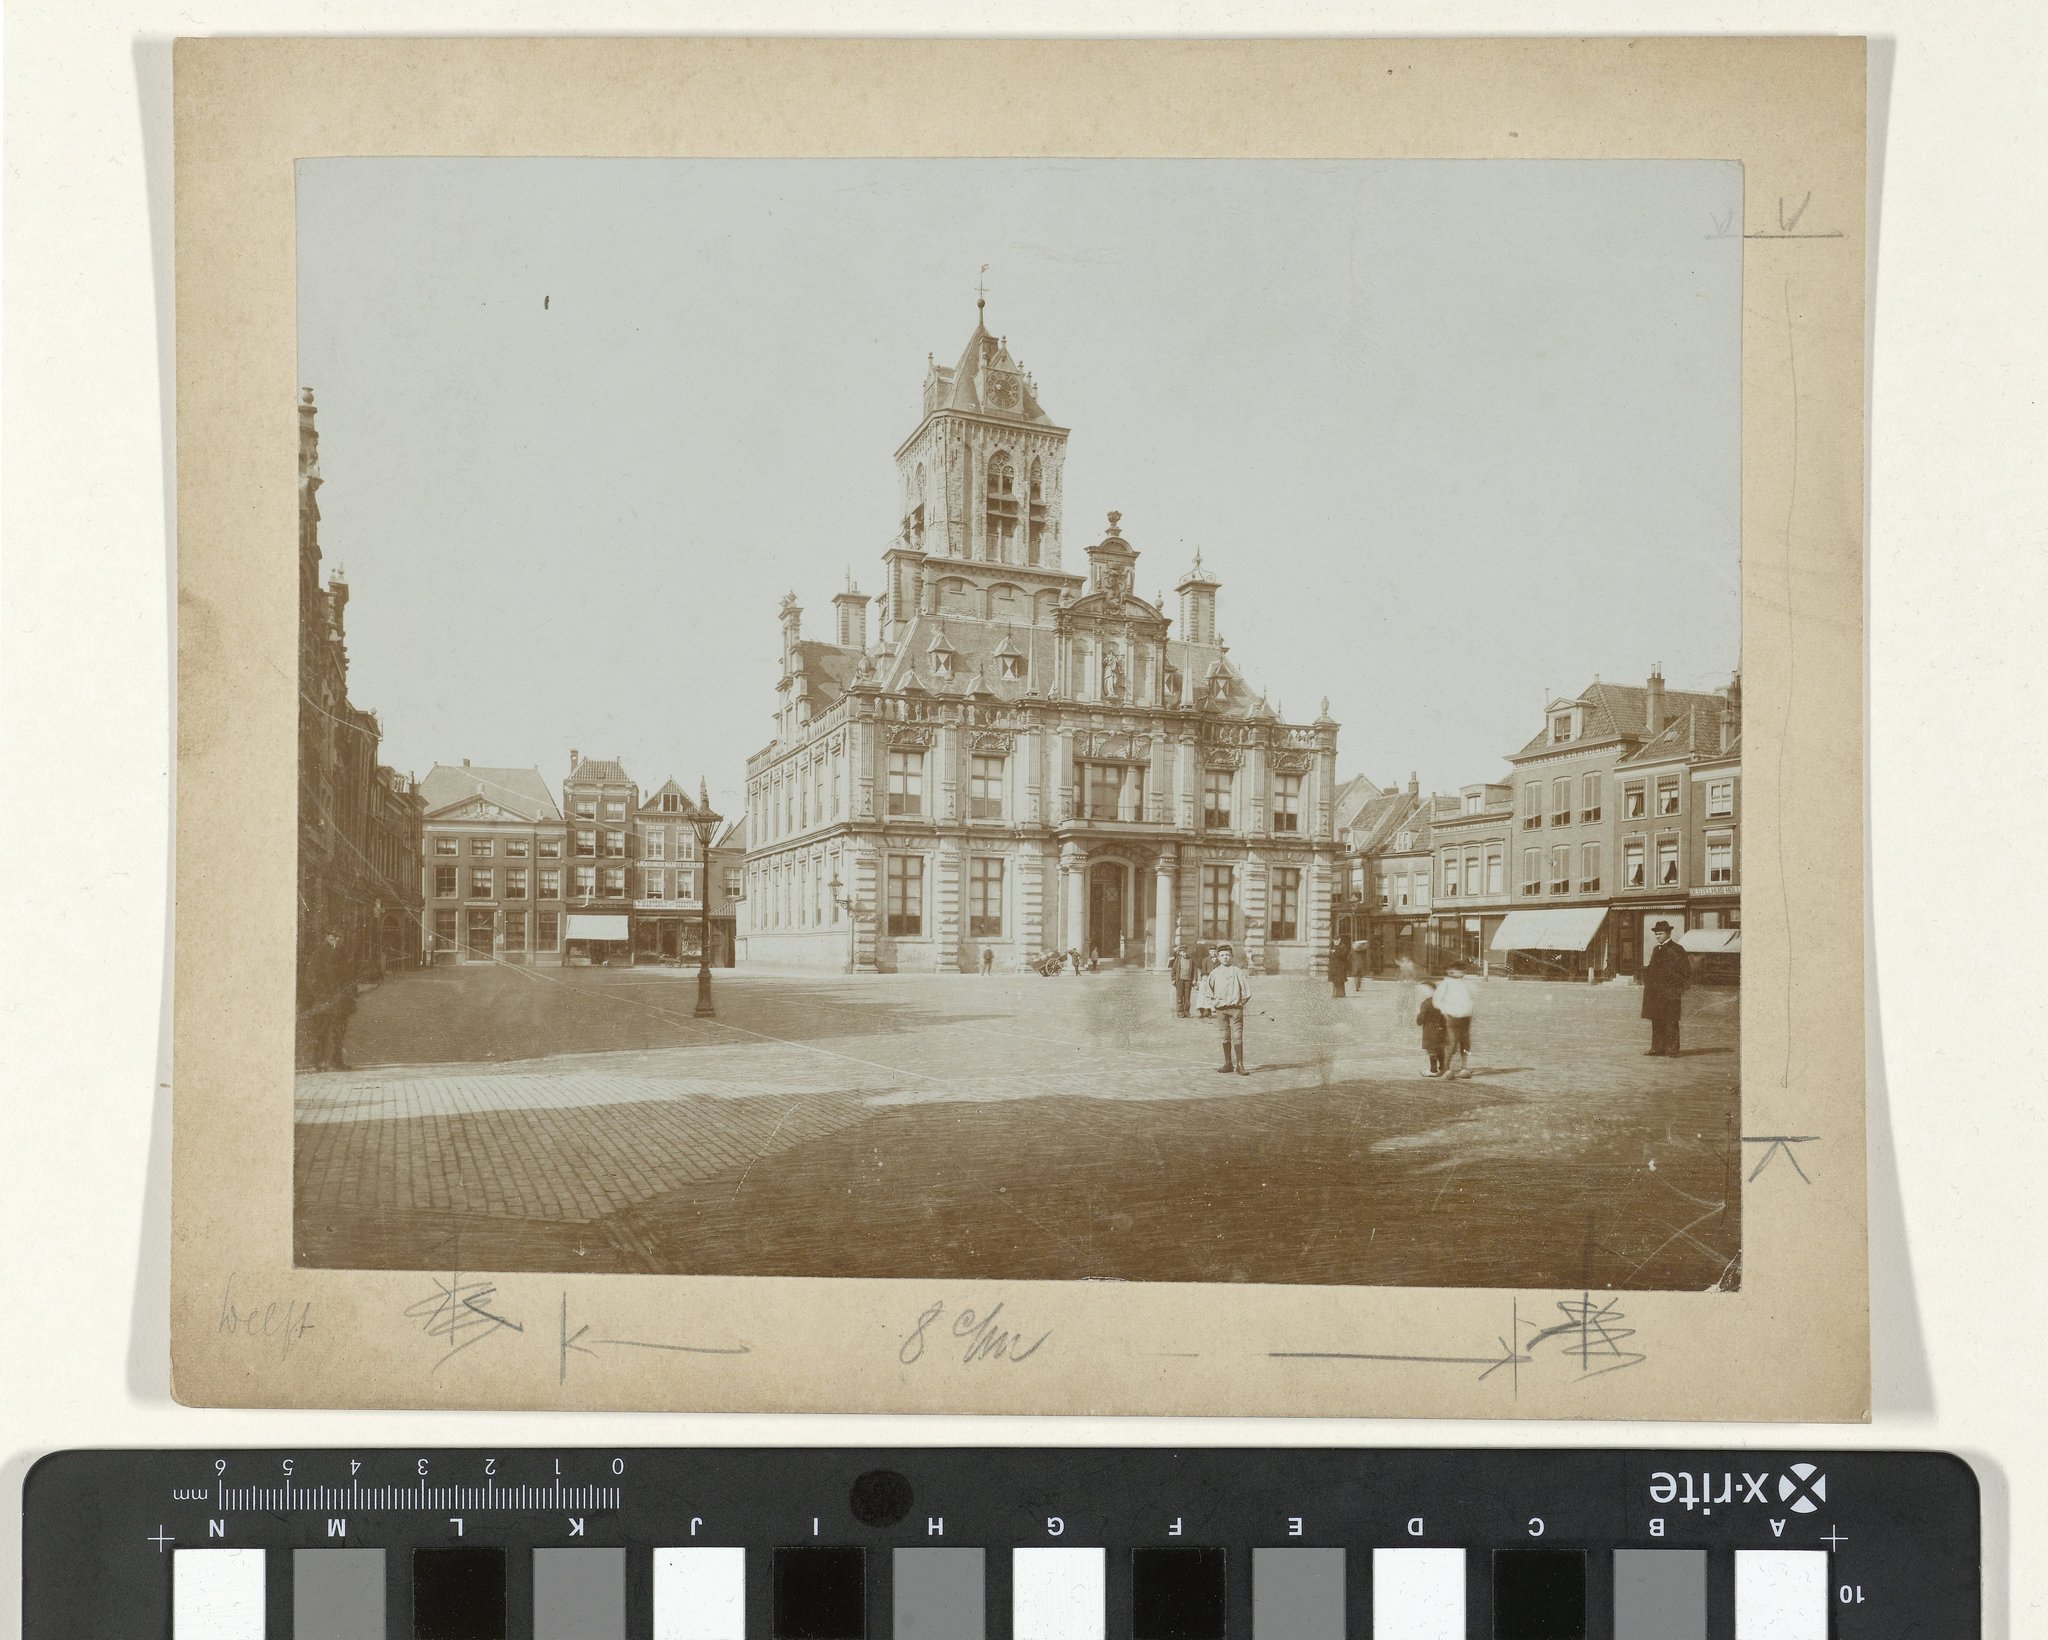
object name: photograph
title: Stadhuis in Delft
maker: Anonymous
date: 1880-1940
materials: cardboard, photographic support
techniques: albumen print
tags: stadhuis